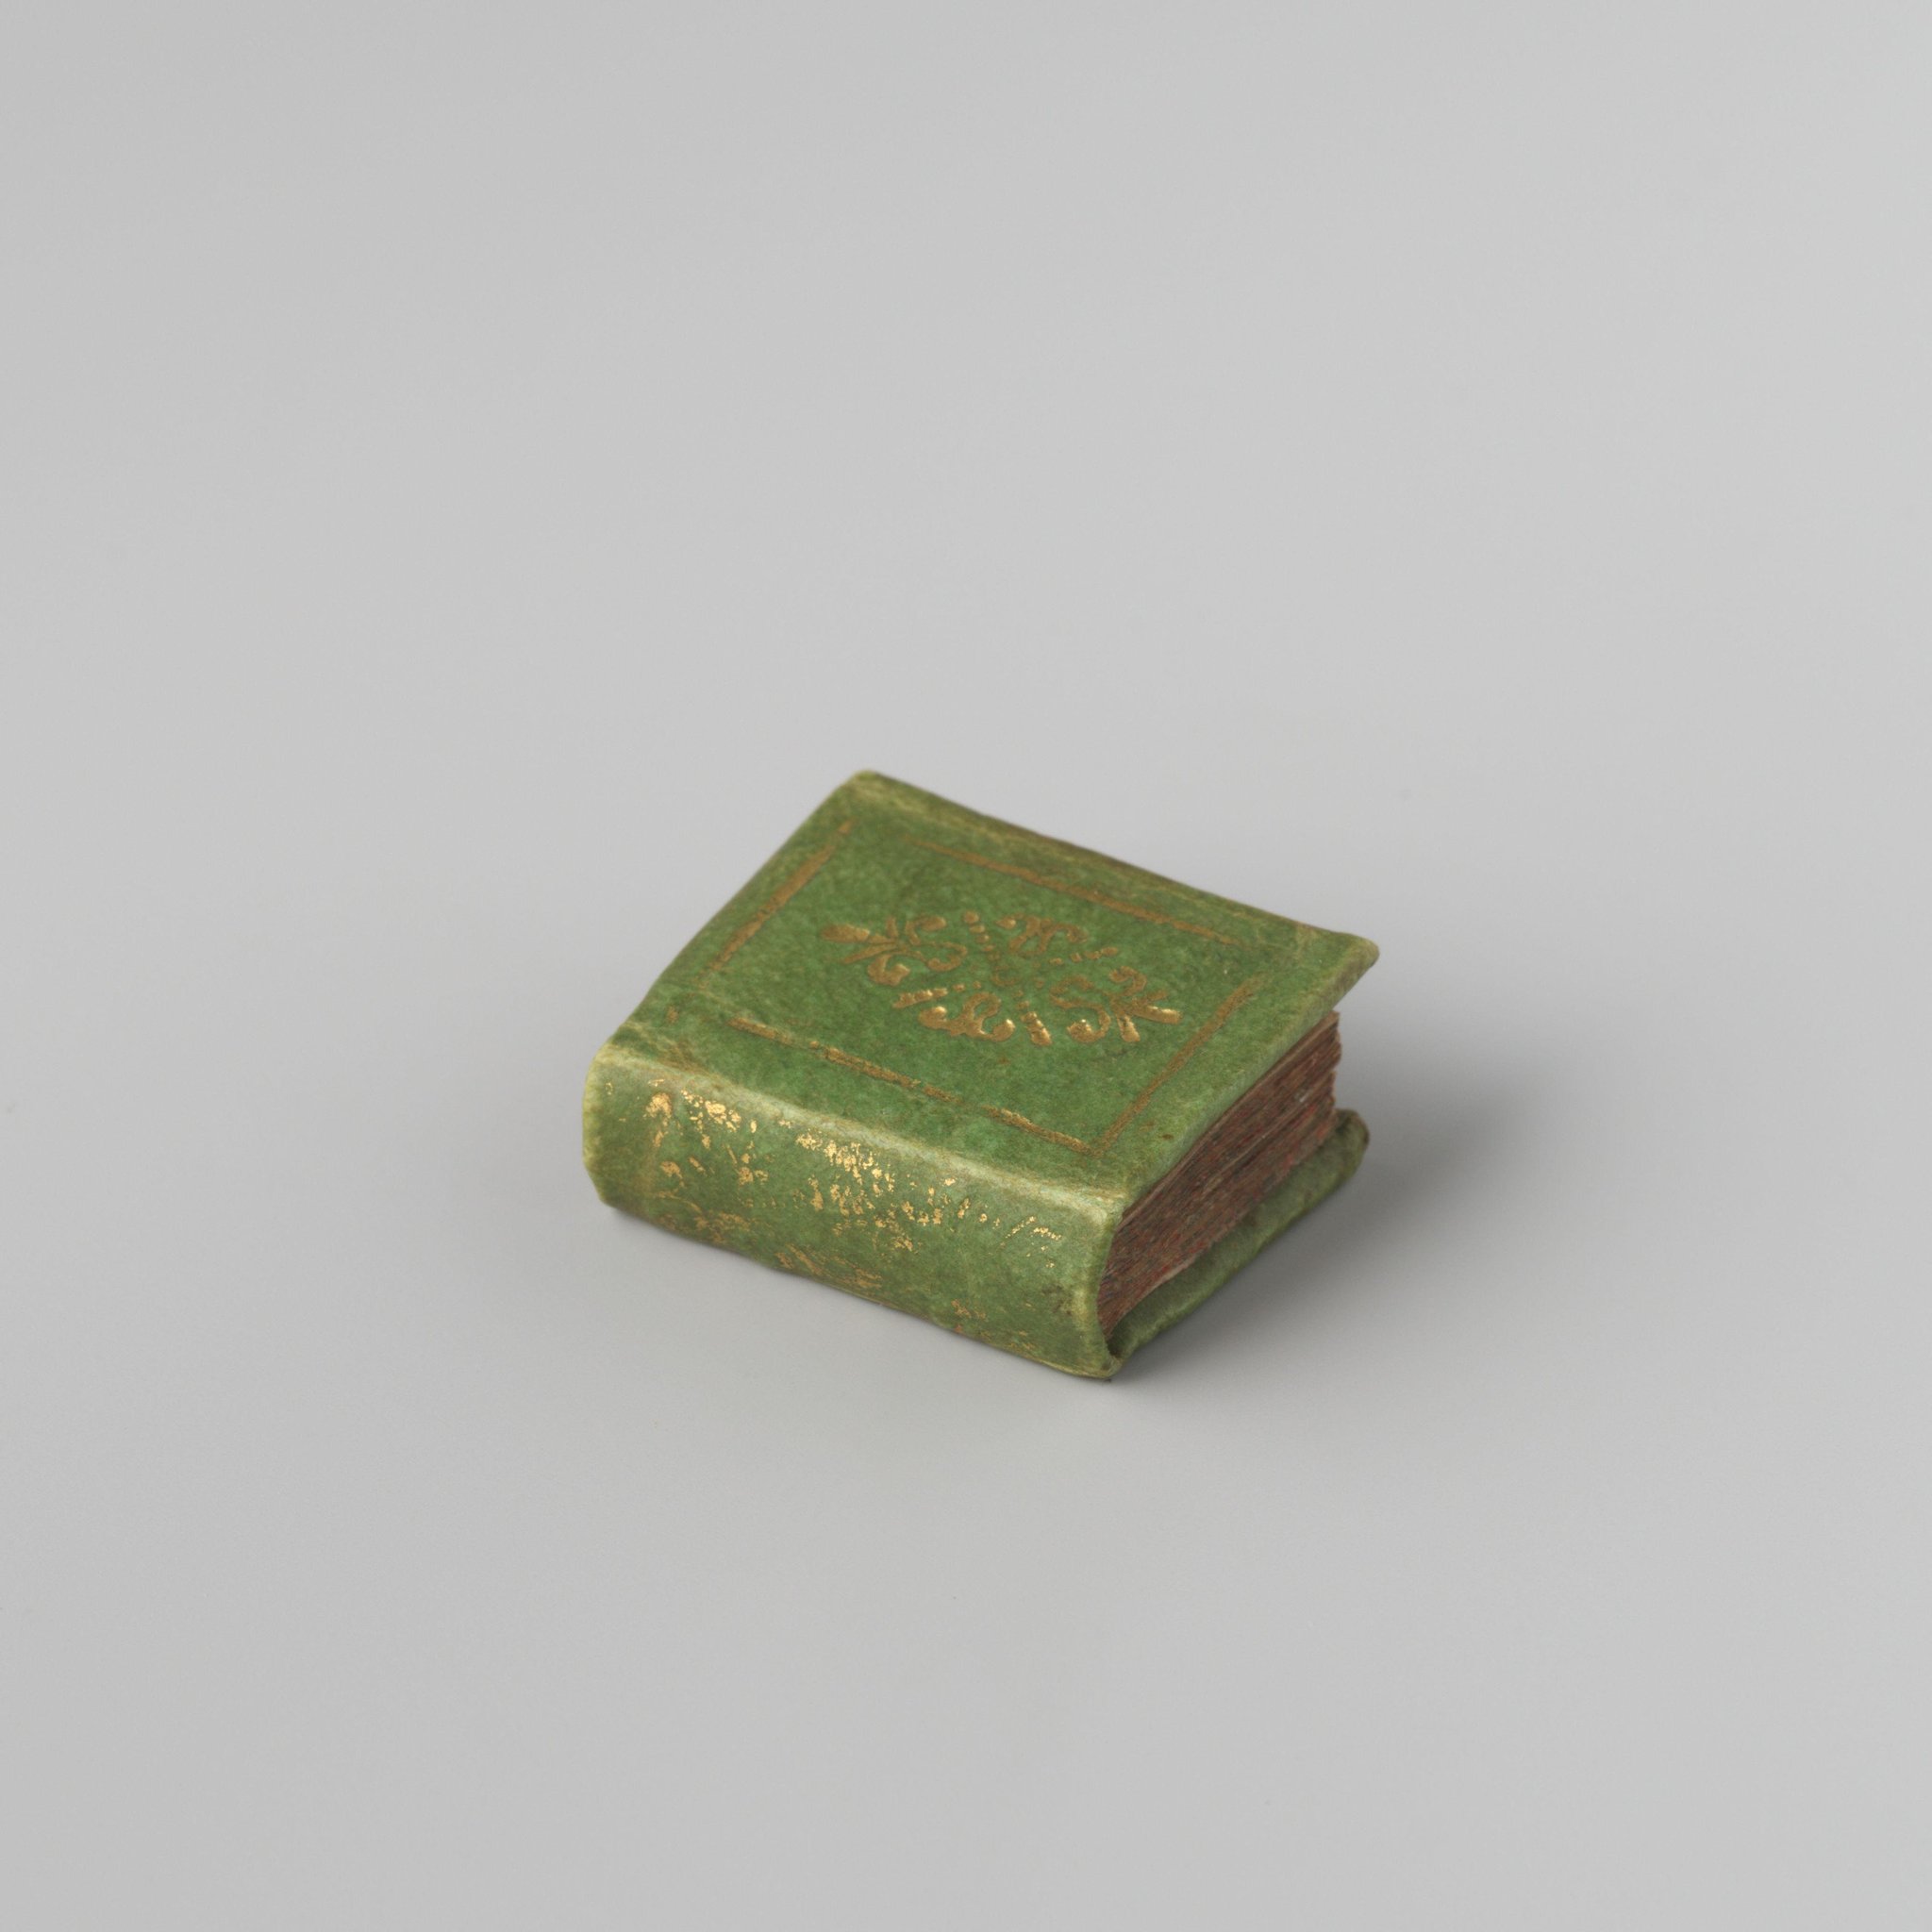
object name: miniature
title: Boek met figuren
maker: Anonymous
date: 1690-1710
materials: gold, paper, parchment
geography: amsterdam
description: Boek met figuren. Ingebonden in groen gekleurd perkament met goudopdruk.